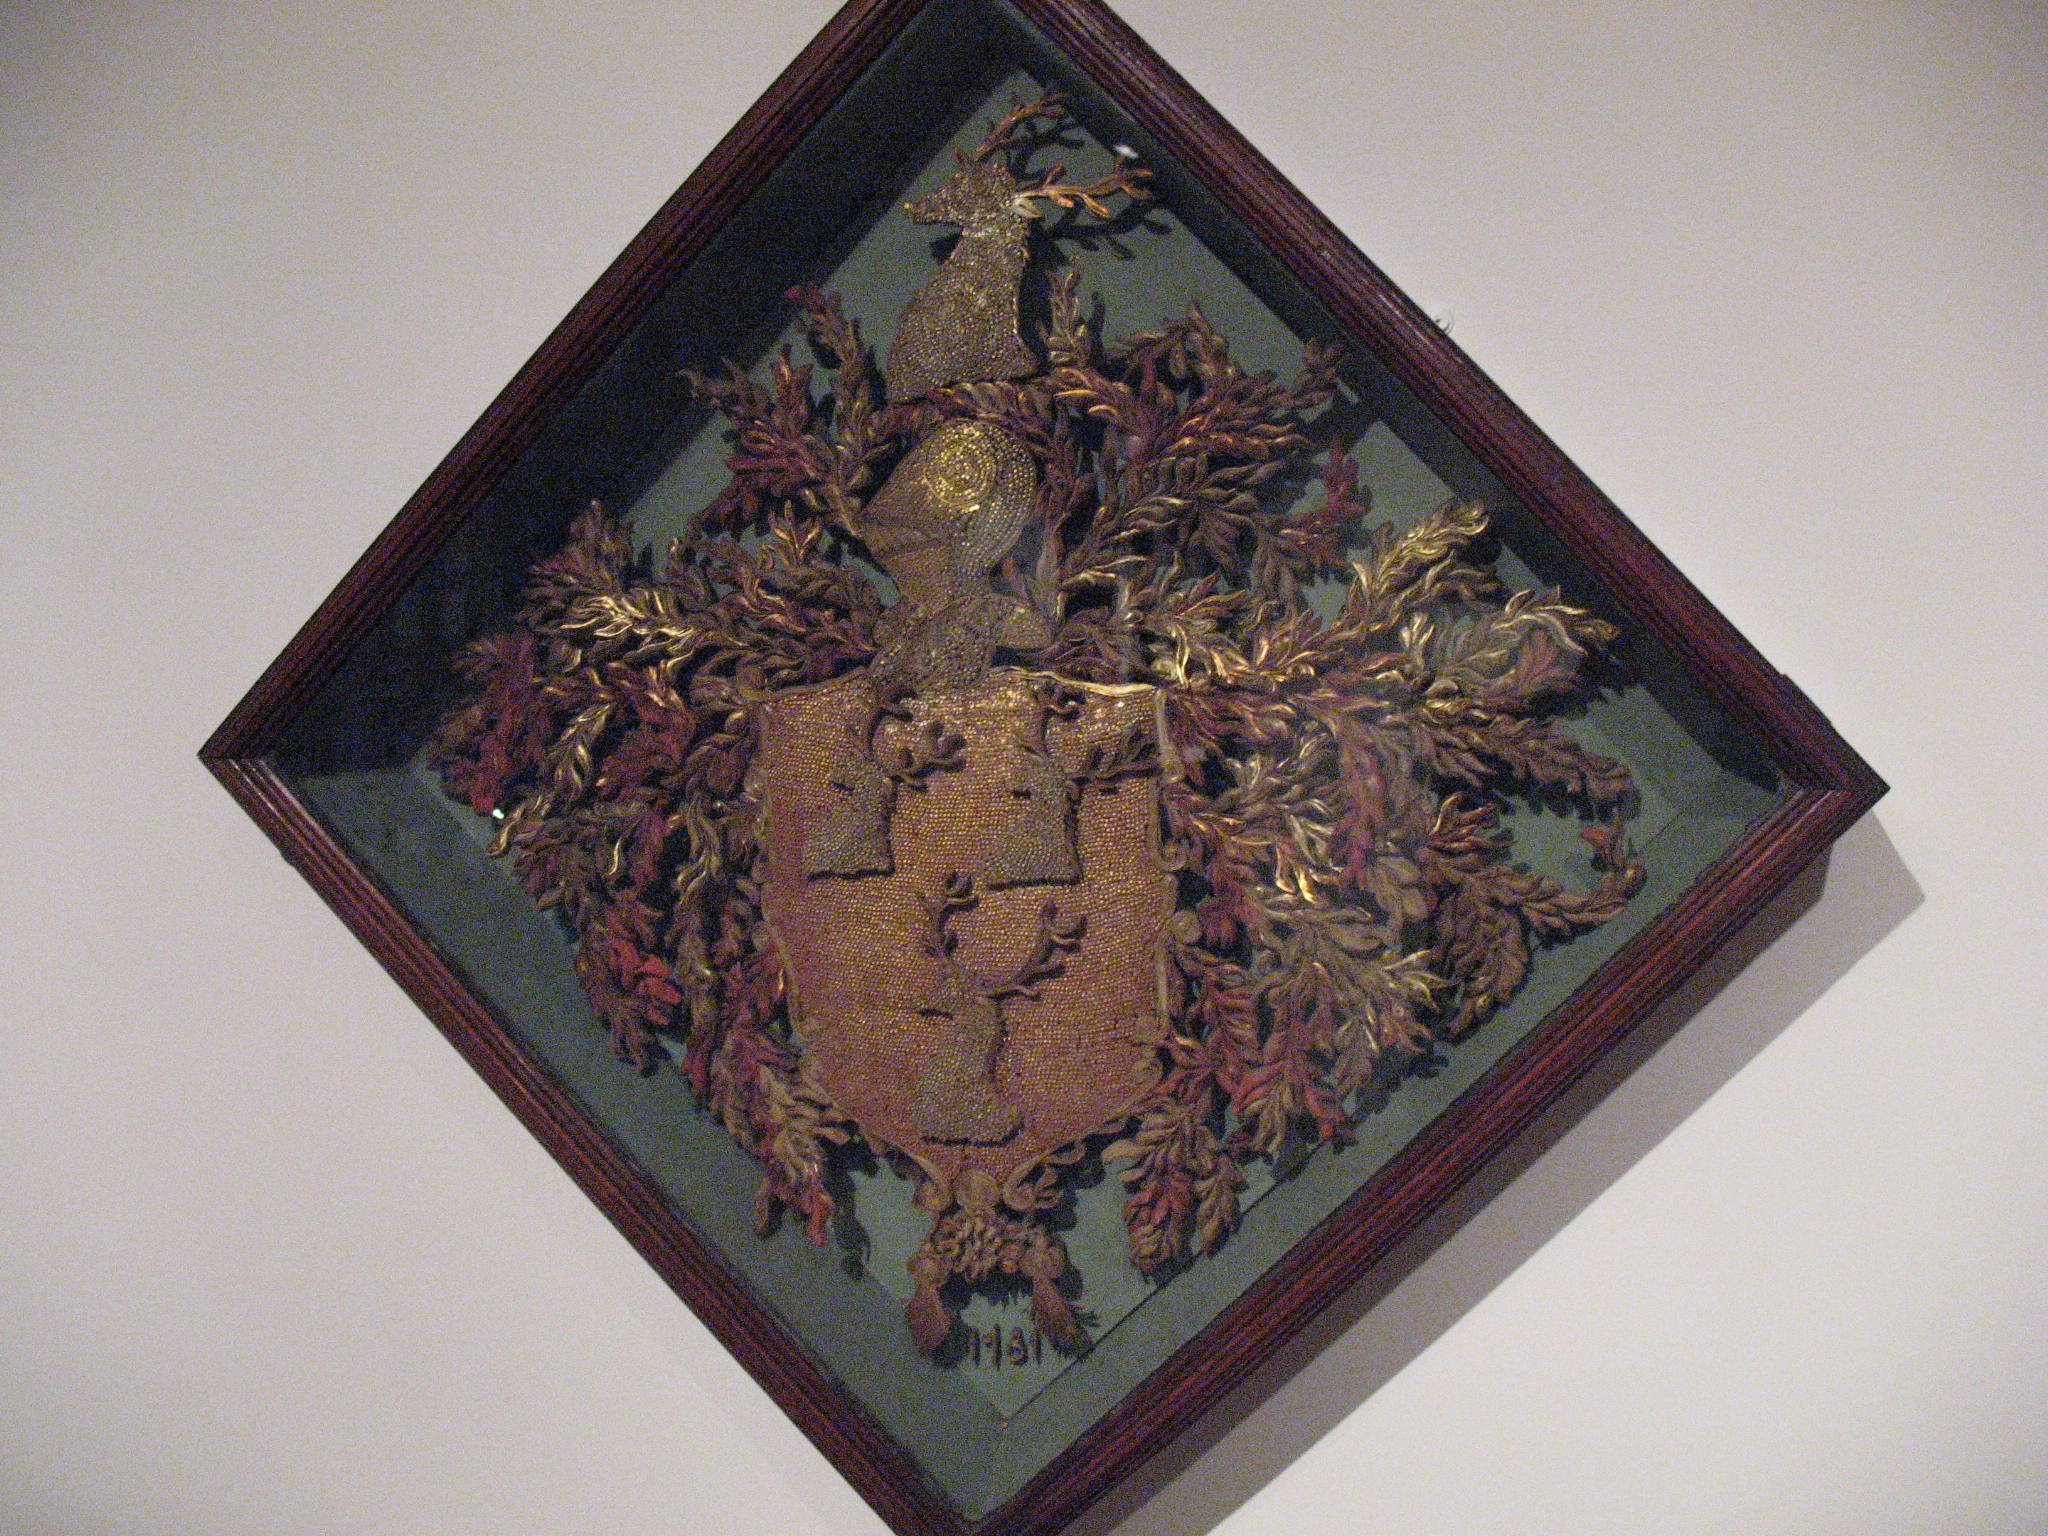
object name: coat of arm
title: Quillwork hatchment of Dering coat of arms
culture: american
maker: mary dering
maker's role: maker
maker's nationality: american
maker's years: 1717-1779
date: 1731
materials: glass, mica, paper, pearl, wood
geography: united states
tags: coat of arms